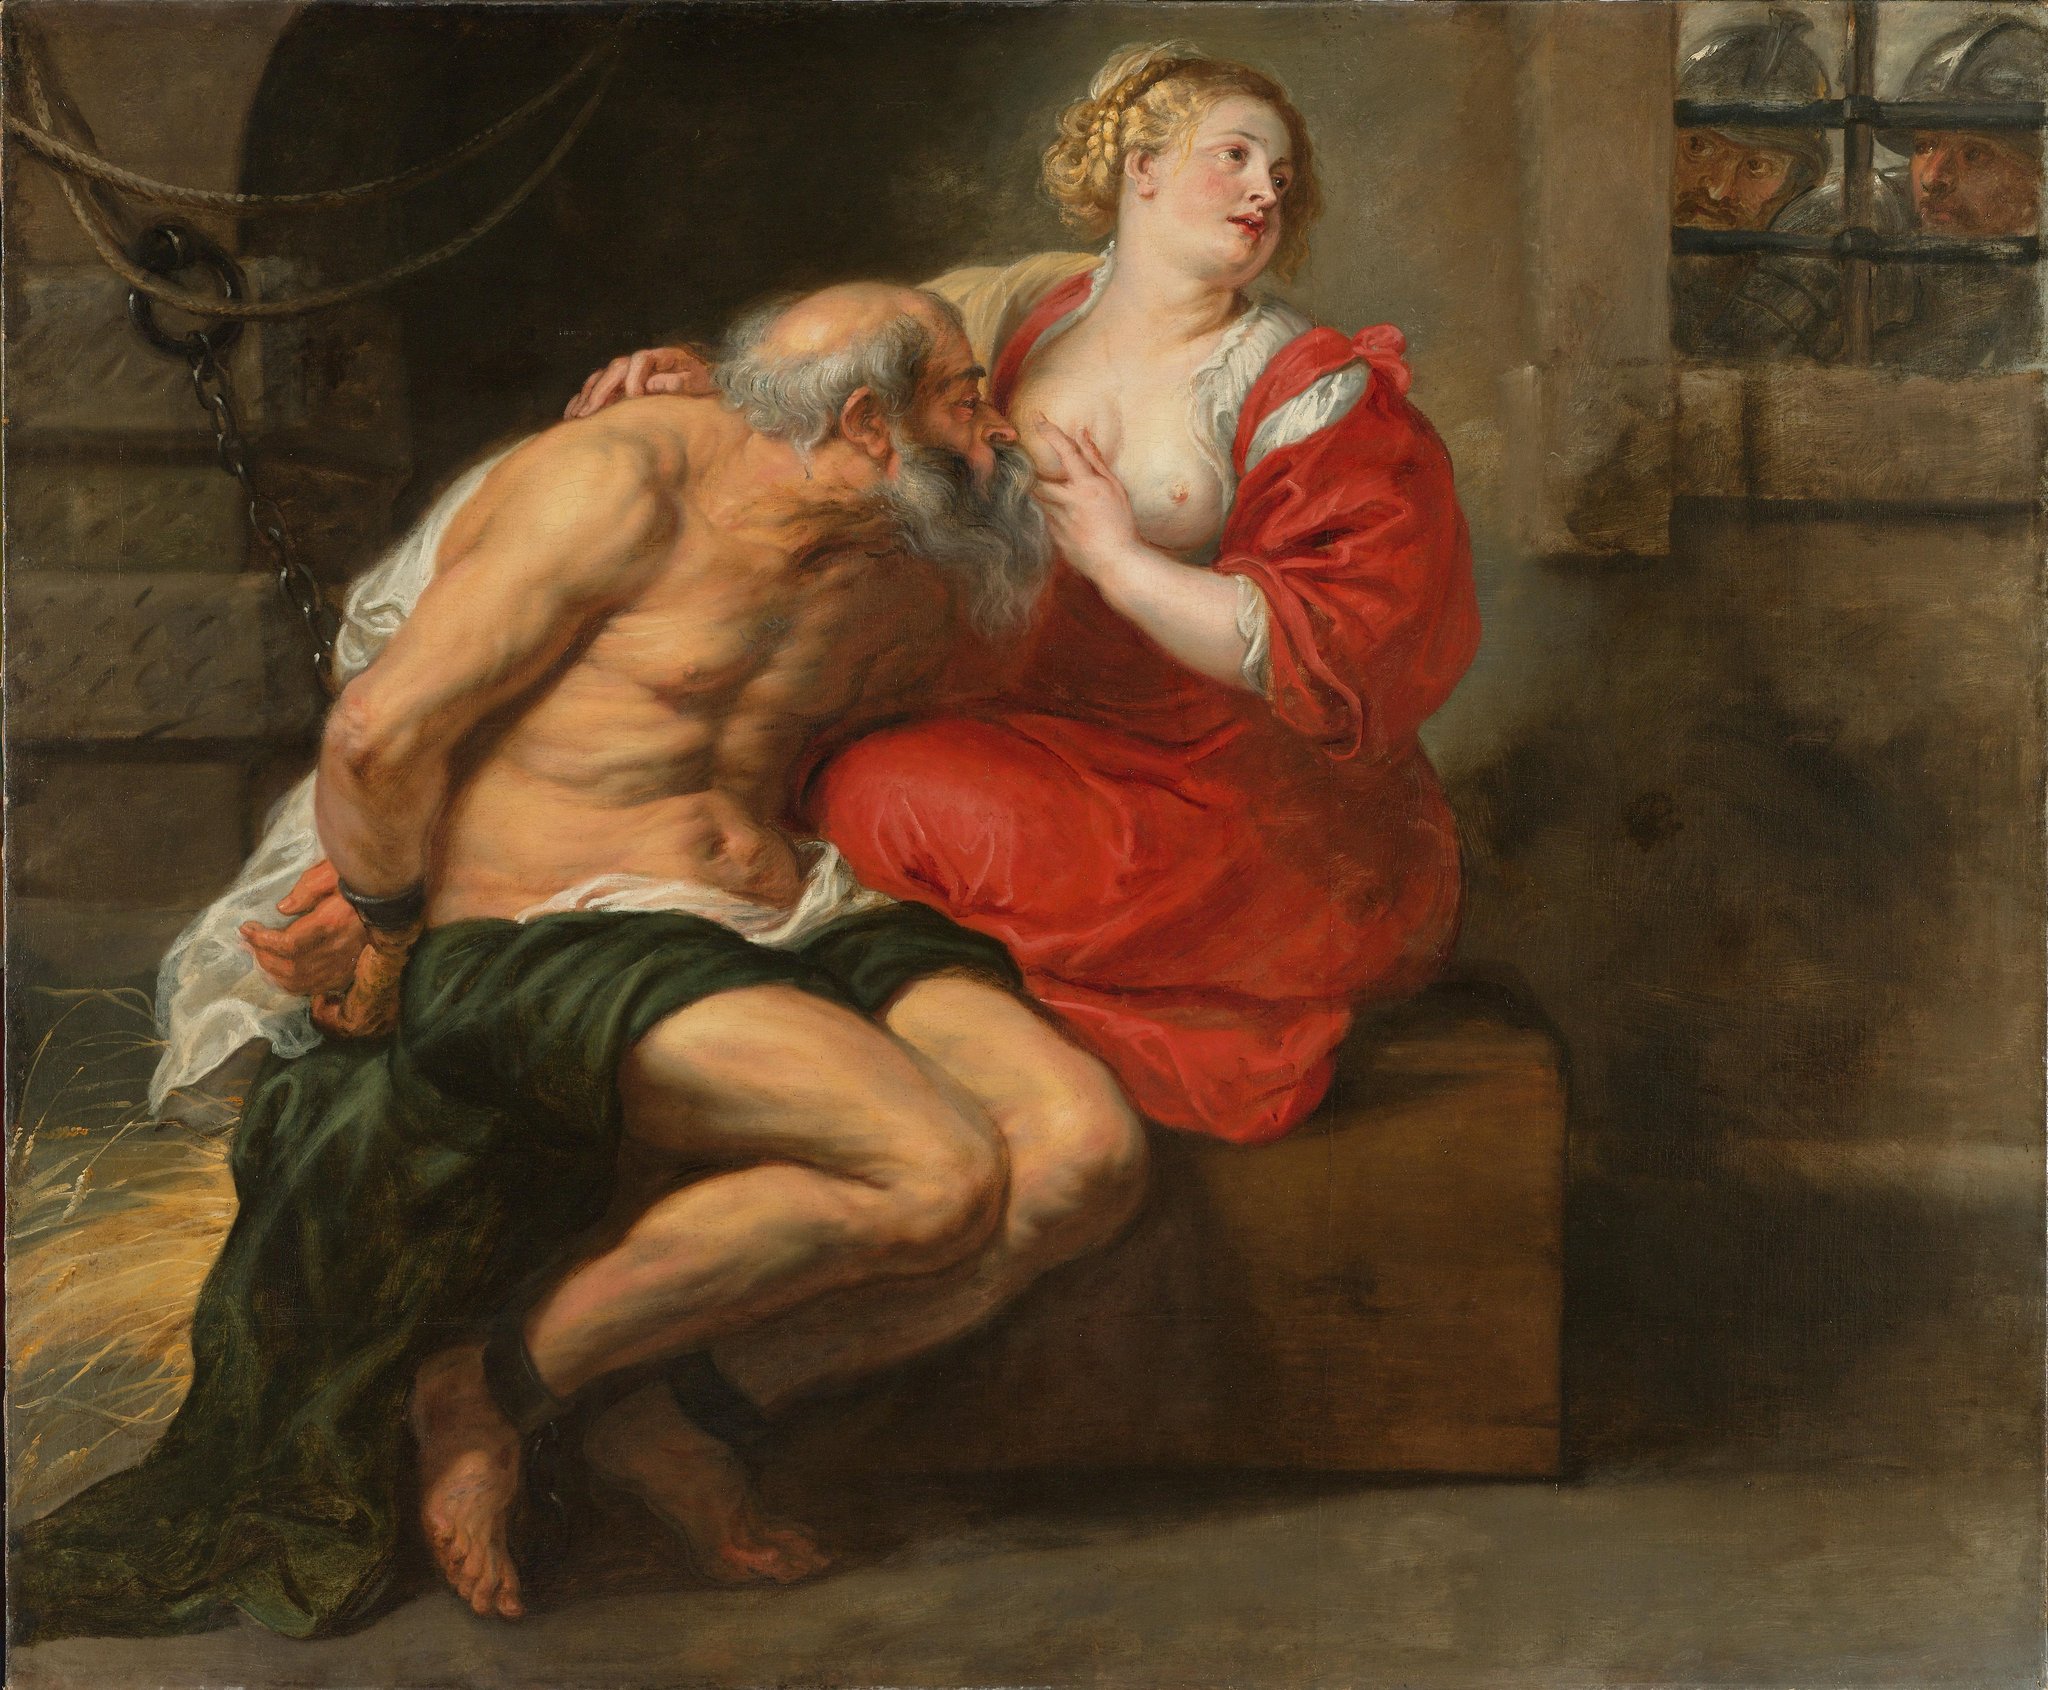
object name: painting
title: Cimon and Pero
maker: peter paul rubens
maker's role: draughtsman, painter, print maker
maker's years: 1577-1640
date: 1635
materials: canvas, oil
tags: pero suckling cimon ('caritas romana')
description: Peter Paul Rubens (1577 - 1640). Cimon and Pero, c. 1630. The remarkable story of Cimon and Pero dates from ancient Rome. Cimon was an old man who was held prisoner and was given nothing to eat. His daughter Pero kept him alive by secretly feeding him from her breast. The story was regarded as the epitome of filial devotion and sacrifice. It is also referred to as Caritas Romana: Roman charity. Rubens portrayed the old man with loose brushstrokes, characteristic for his later work. He accentuated the contrast between this wrinkled figure and the beautiful young woman. The nosey wardens stealing a glimpse also liven up the scene. Purchased by the Mauritshuis in The Hague in 1822 from Stier van Aerstelaer collection, Antwerp, Acquired by the Rijksmuseum in exchange in 1825.